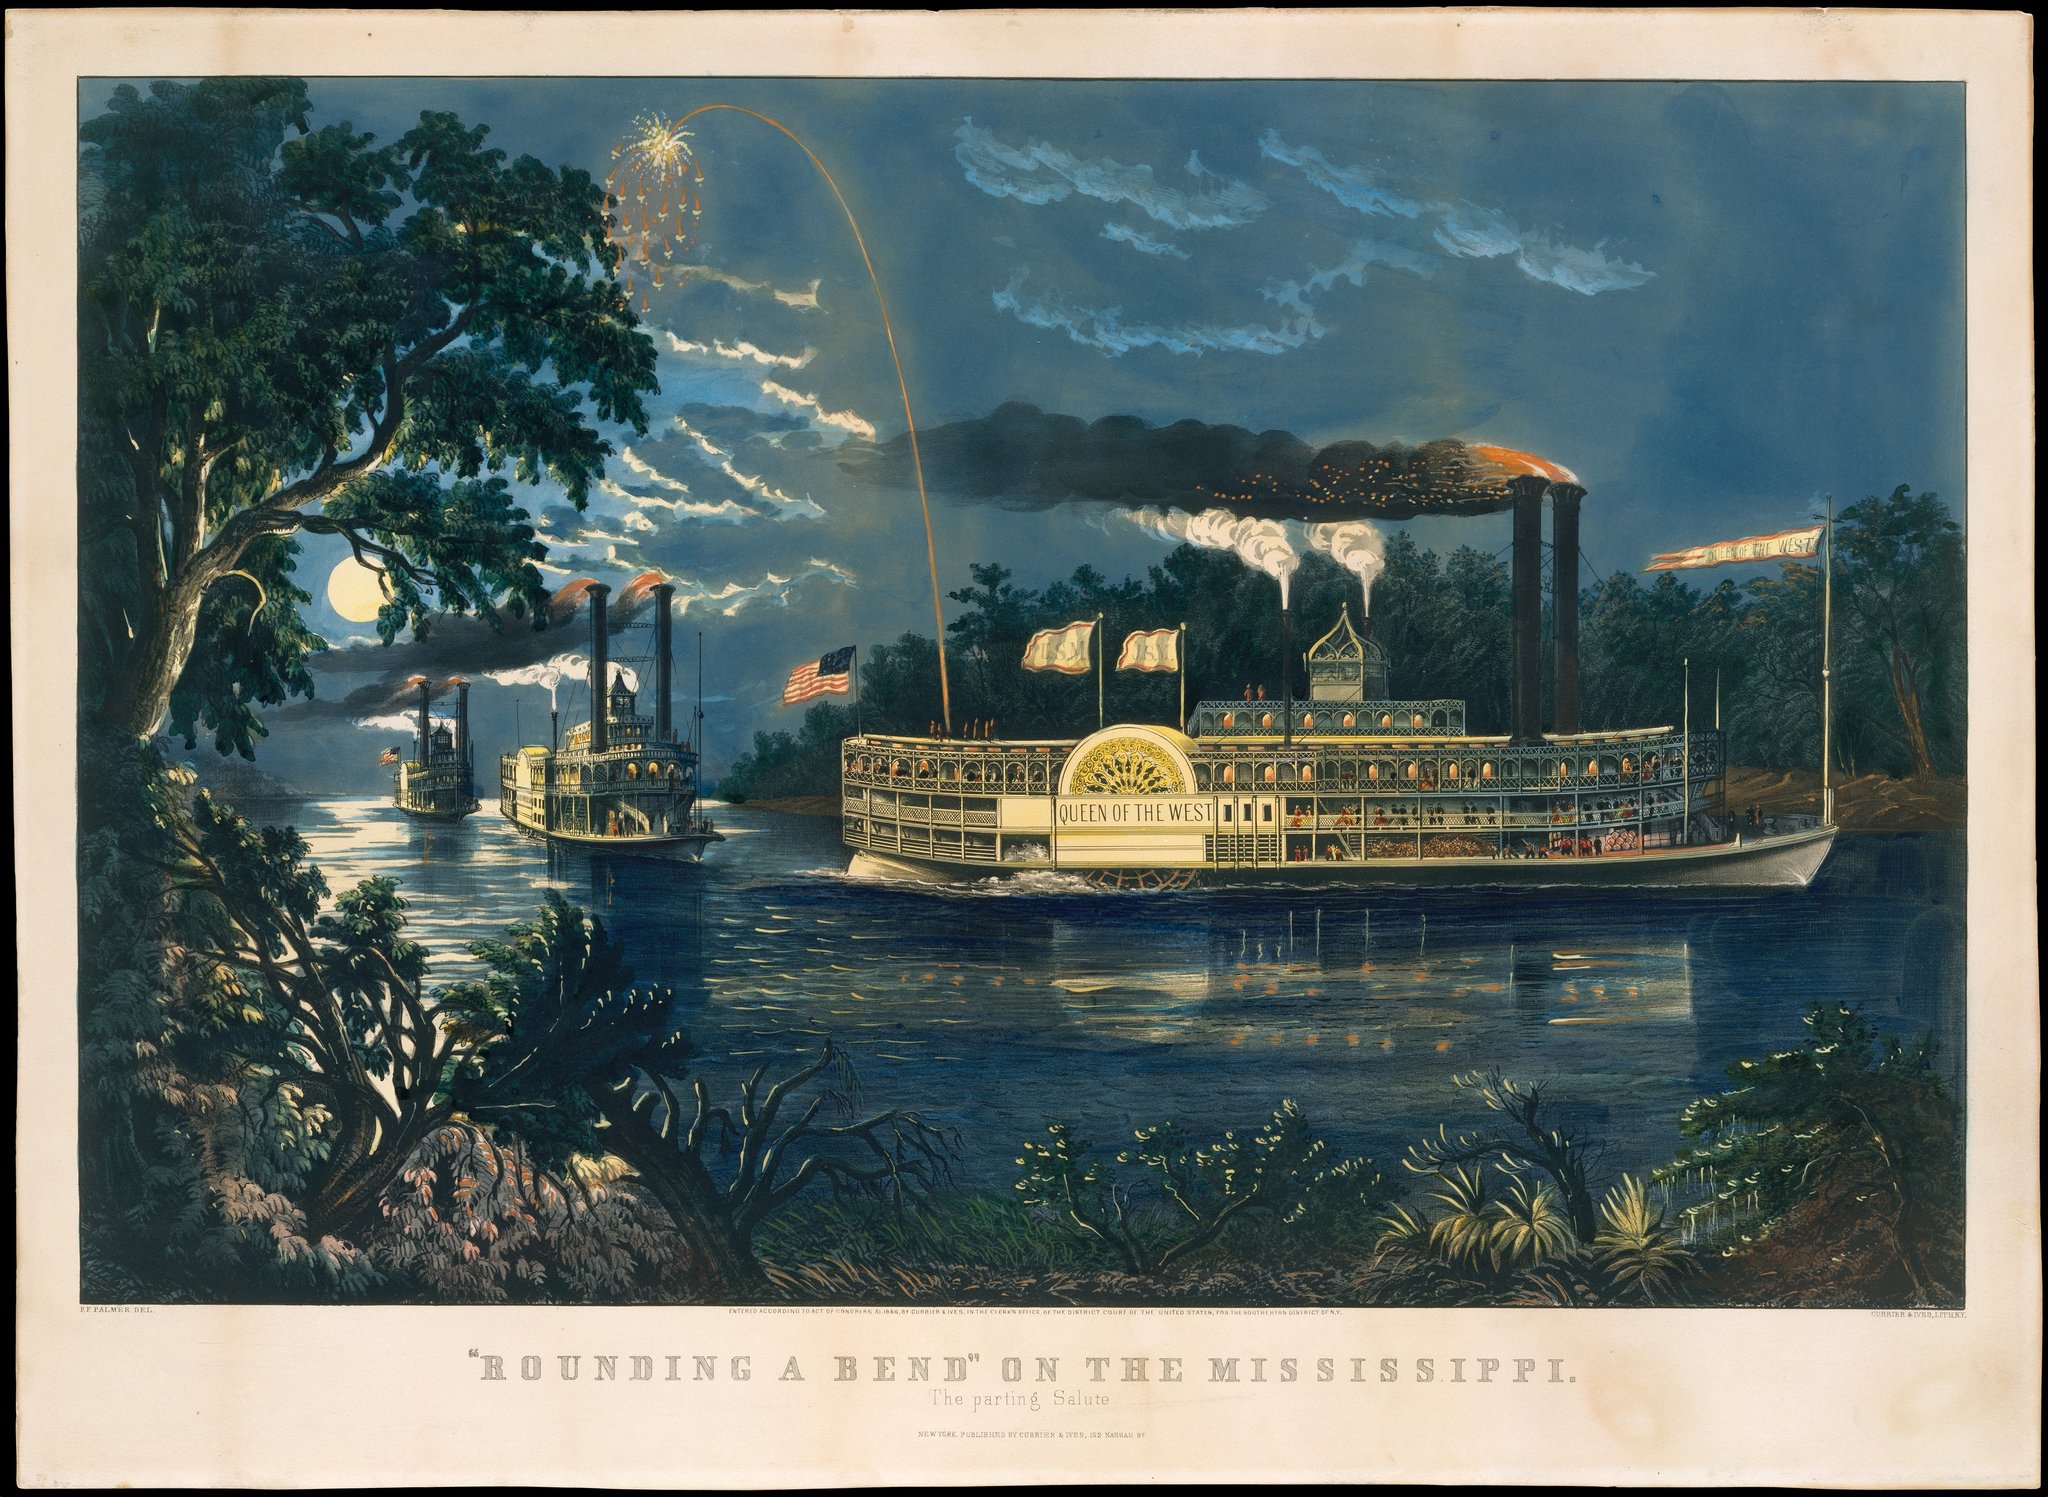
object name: print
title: "Rounding a Bend" on the Mississippi – The Parting Salute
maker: frances flora bond palmer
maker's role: artist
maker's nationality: american, born england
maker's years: 1812-1876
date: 1866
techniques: hand coloring, lithograph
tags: rivers,boats